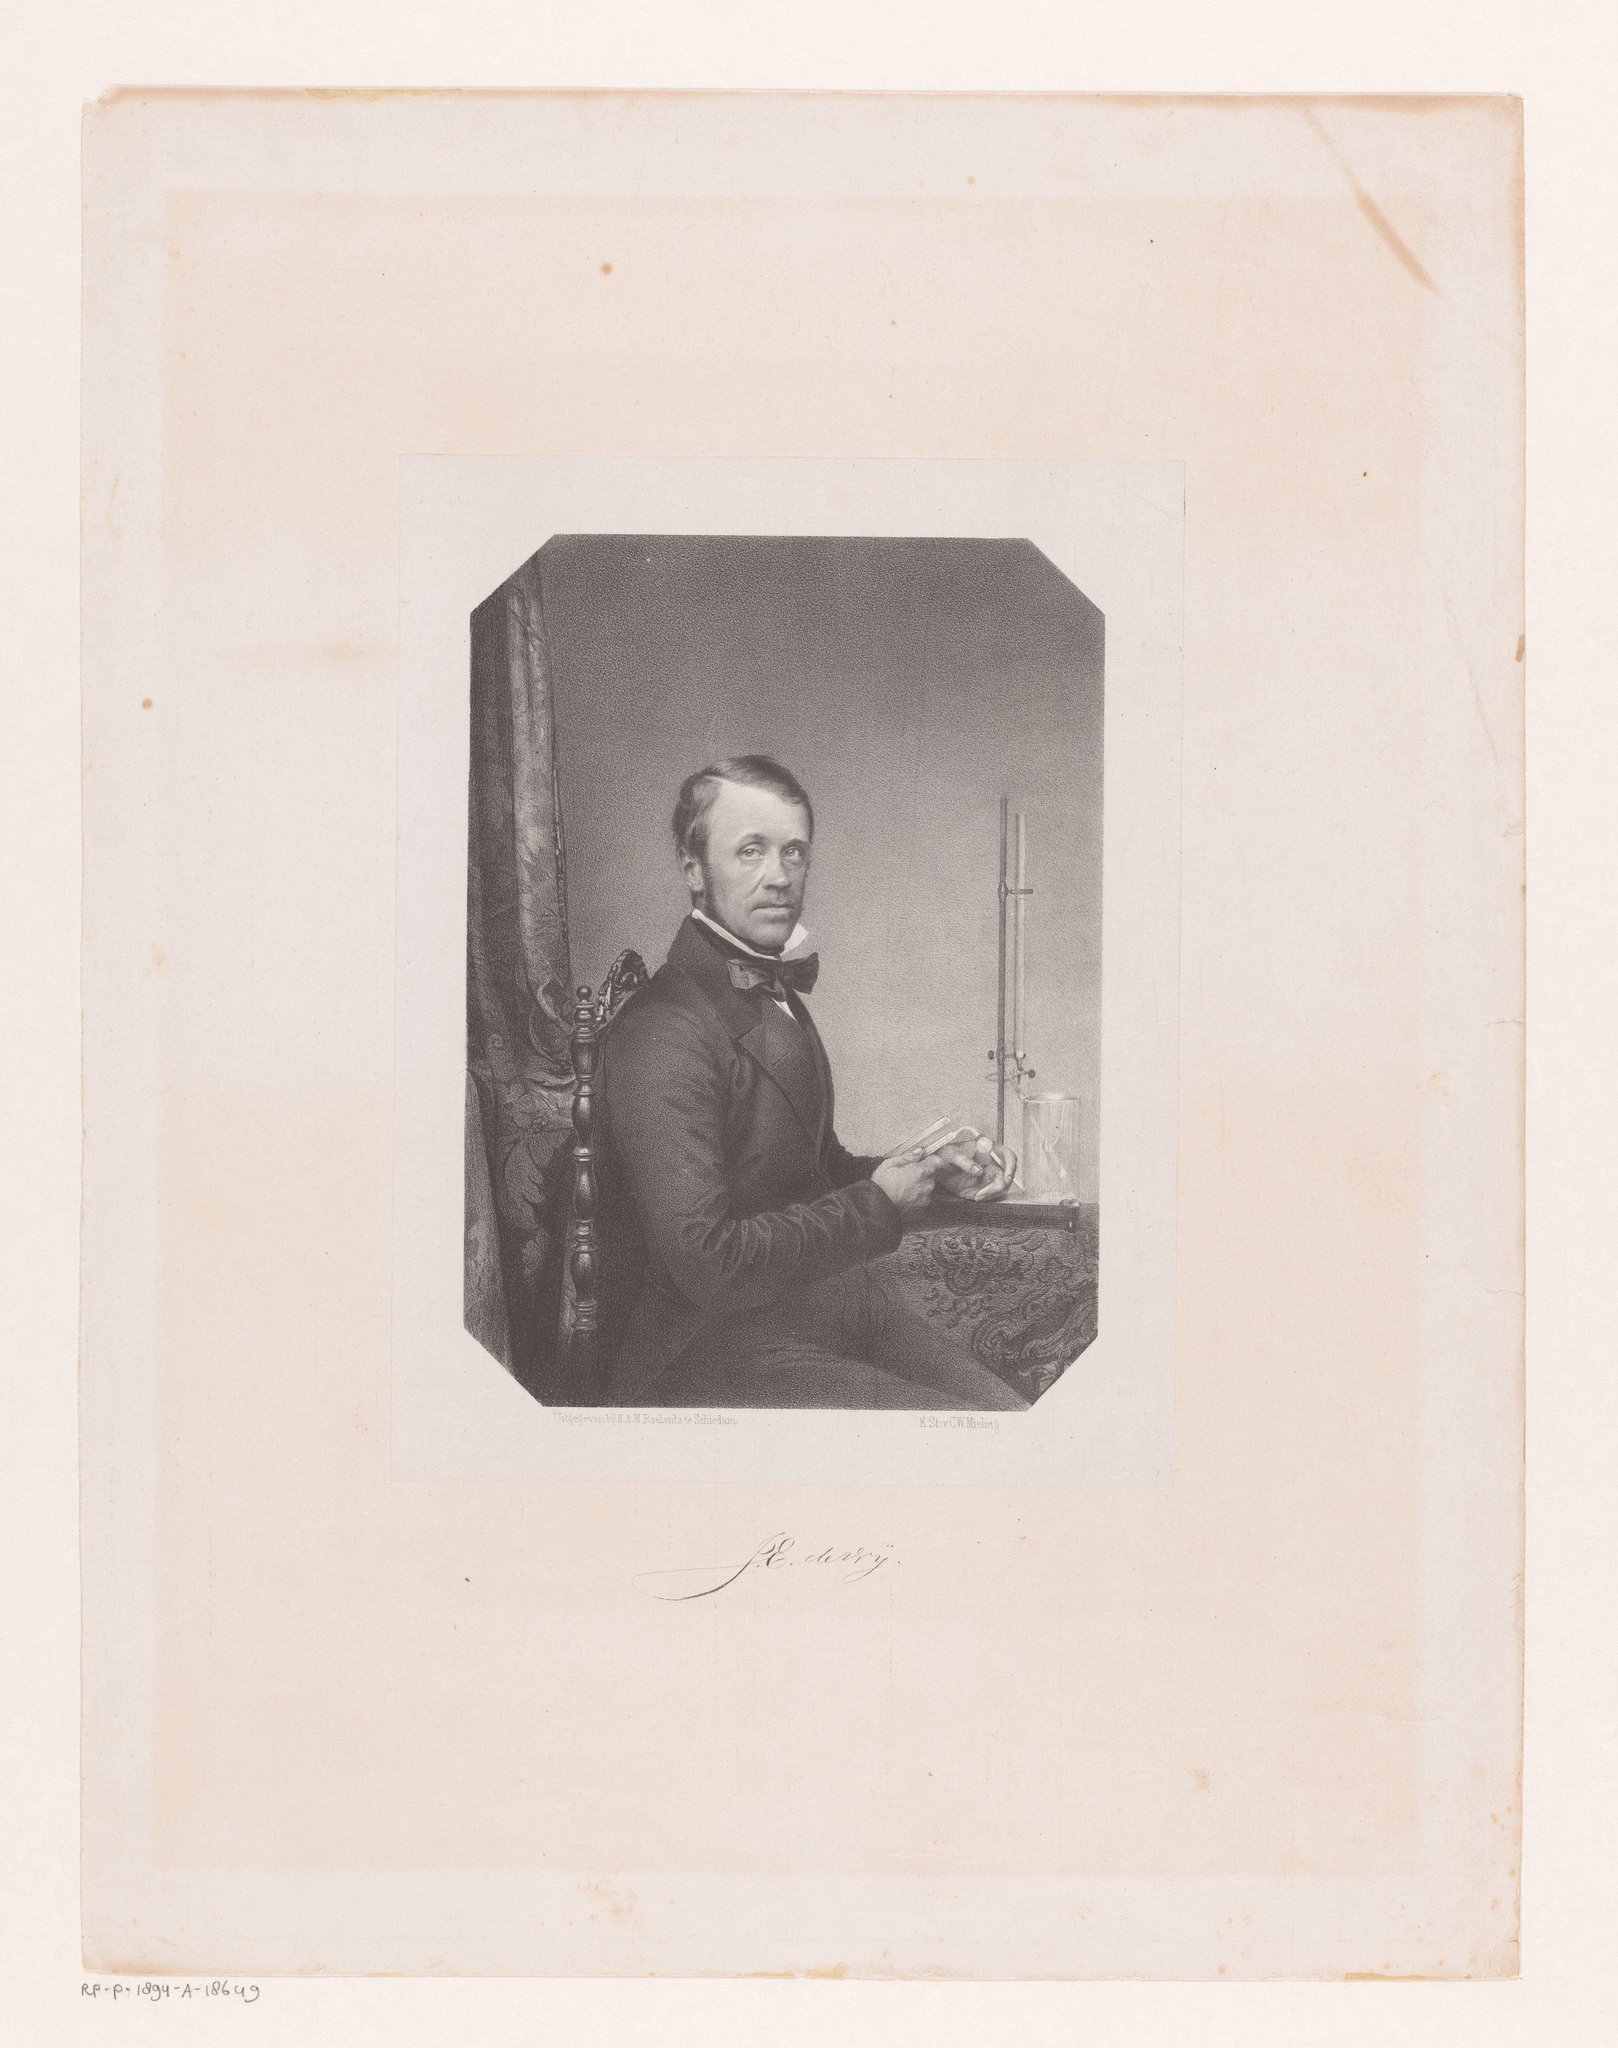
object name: print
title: Portret van apotheker Johannes Eliza de Vrij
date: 1847-1865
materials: paper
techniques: lithograph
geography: the hague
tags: pharmacist, druggist, apothecary; pharmacy, drugstore, dispensing chemist, historical persons (+ half-length portrait)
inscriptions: collector's mark: Lugt 2228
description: De geportretteerde zit aan een tafel met daarop laboratoriumglaswerk. Onder het portret zijn signatuur.